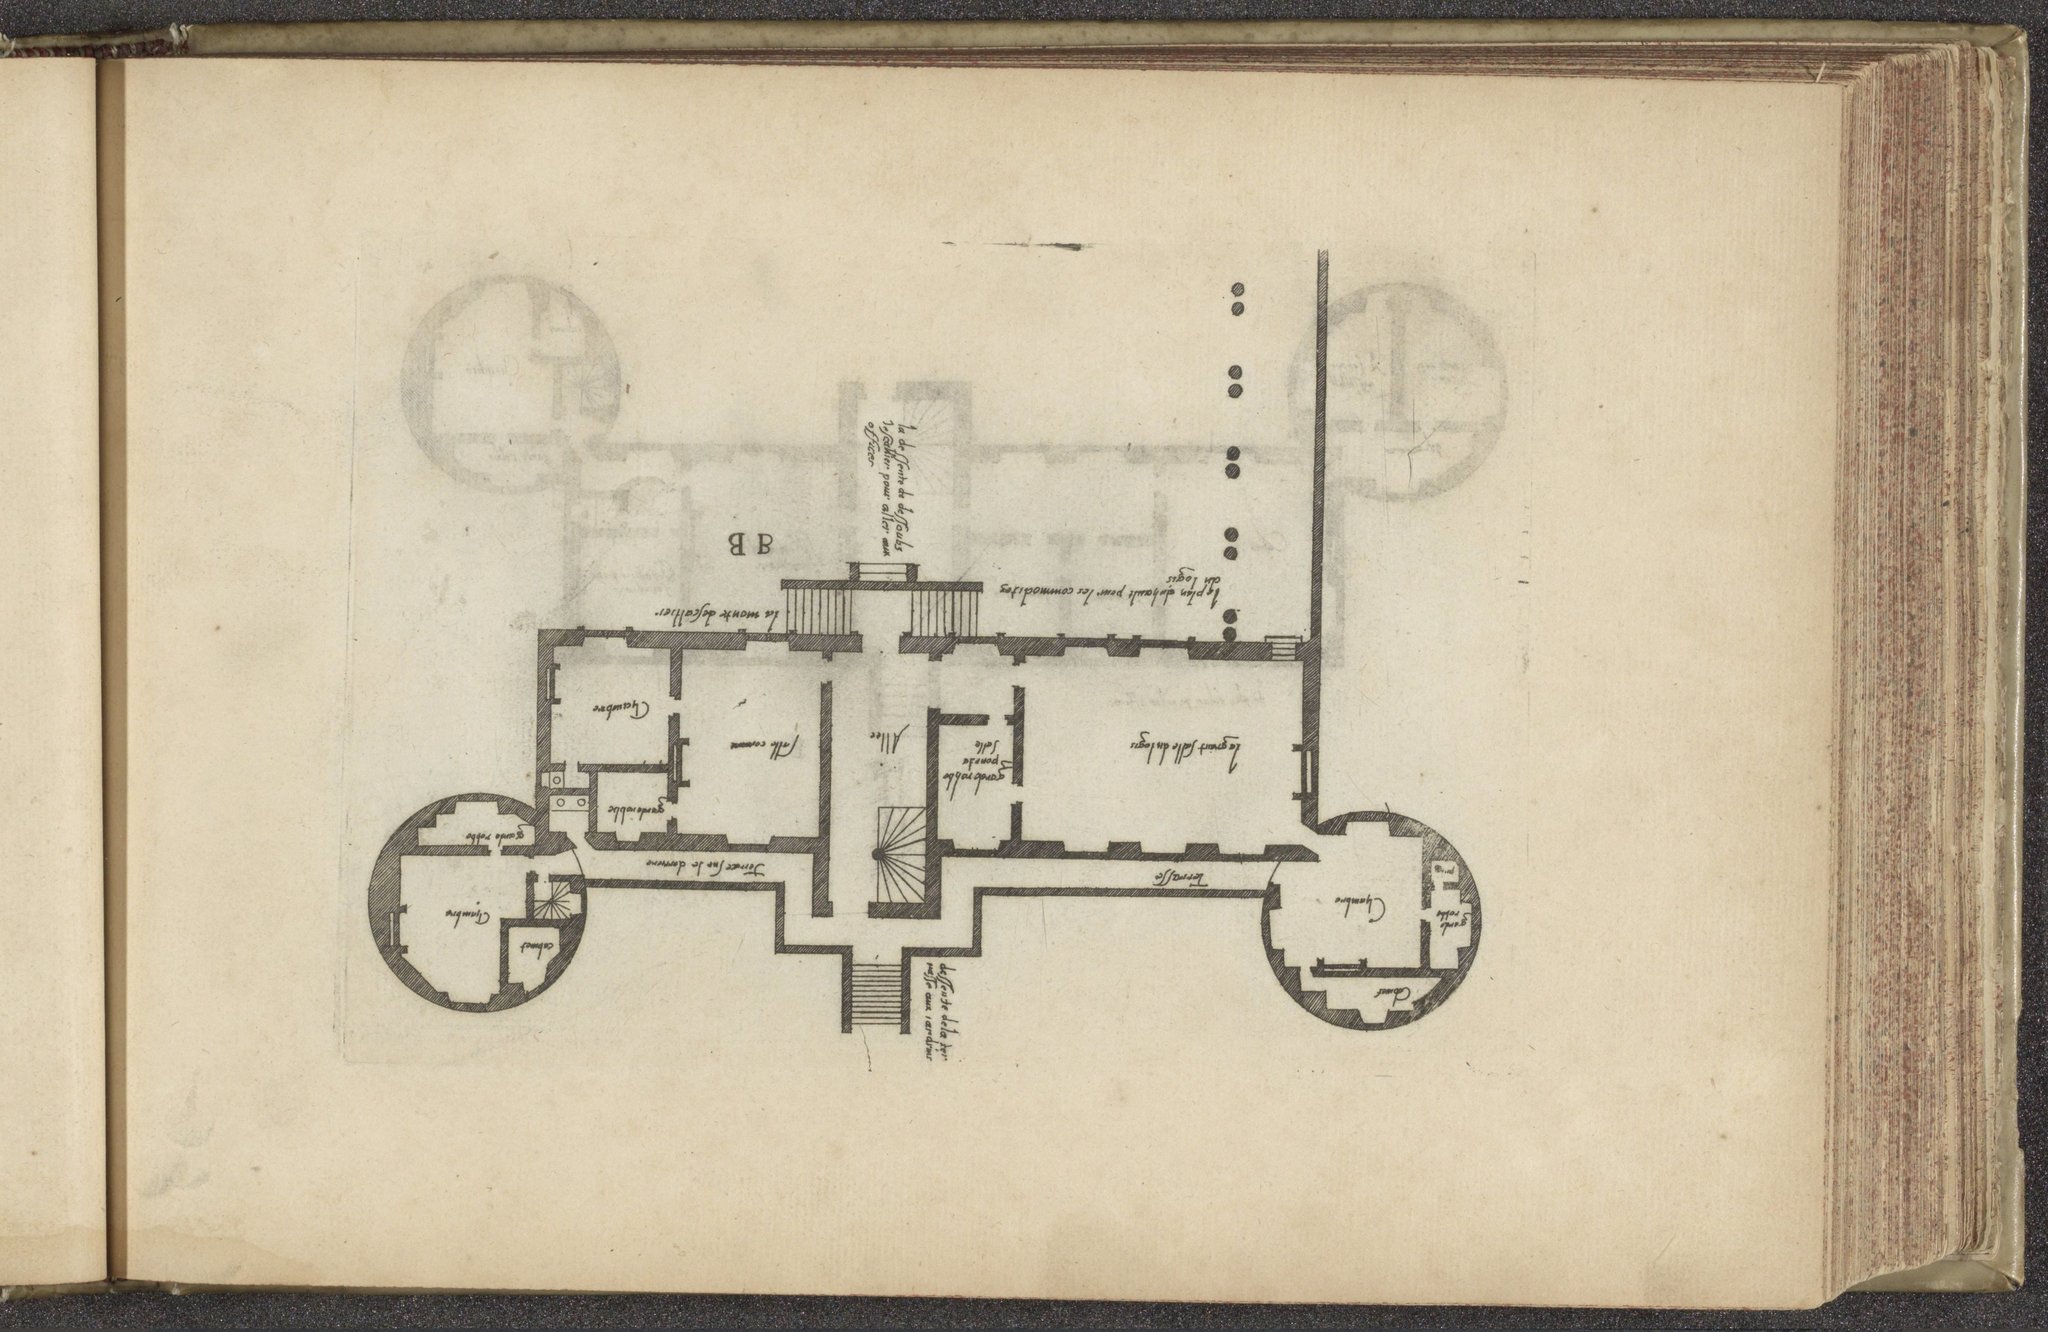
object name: album leaf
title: Logis domestiques / Petit Habitations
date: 1540-1545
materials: paper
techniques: etching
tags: plan ~ architecture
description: Deze prent maakt deel uit van een album.